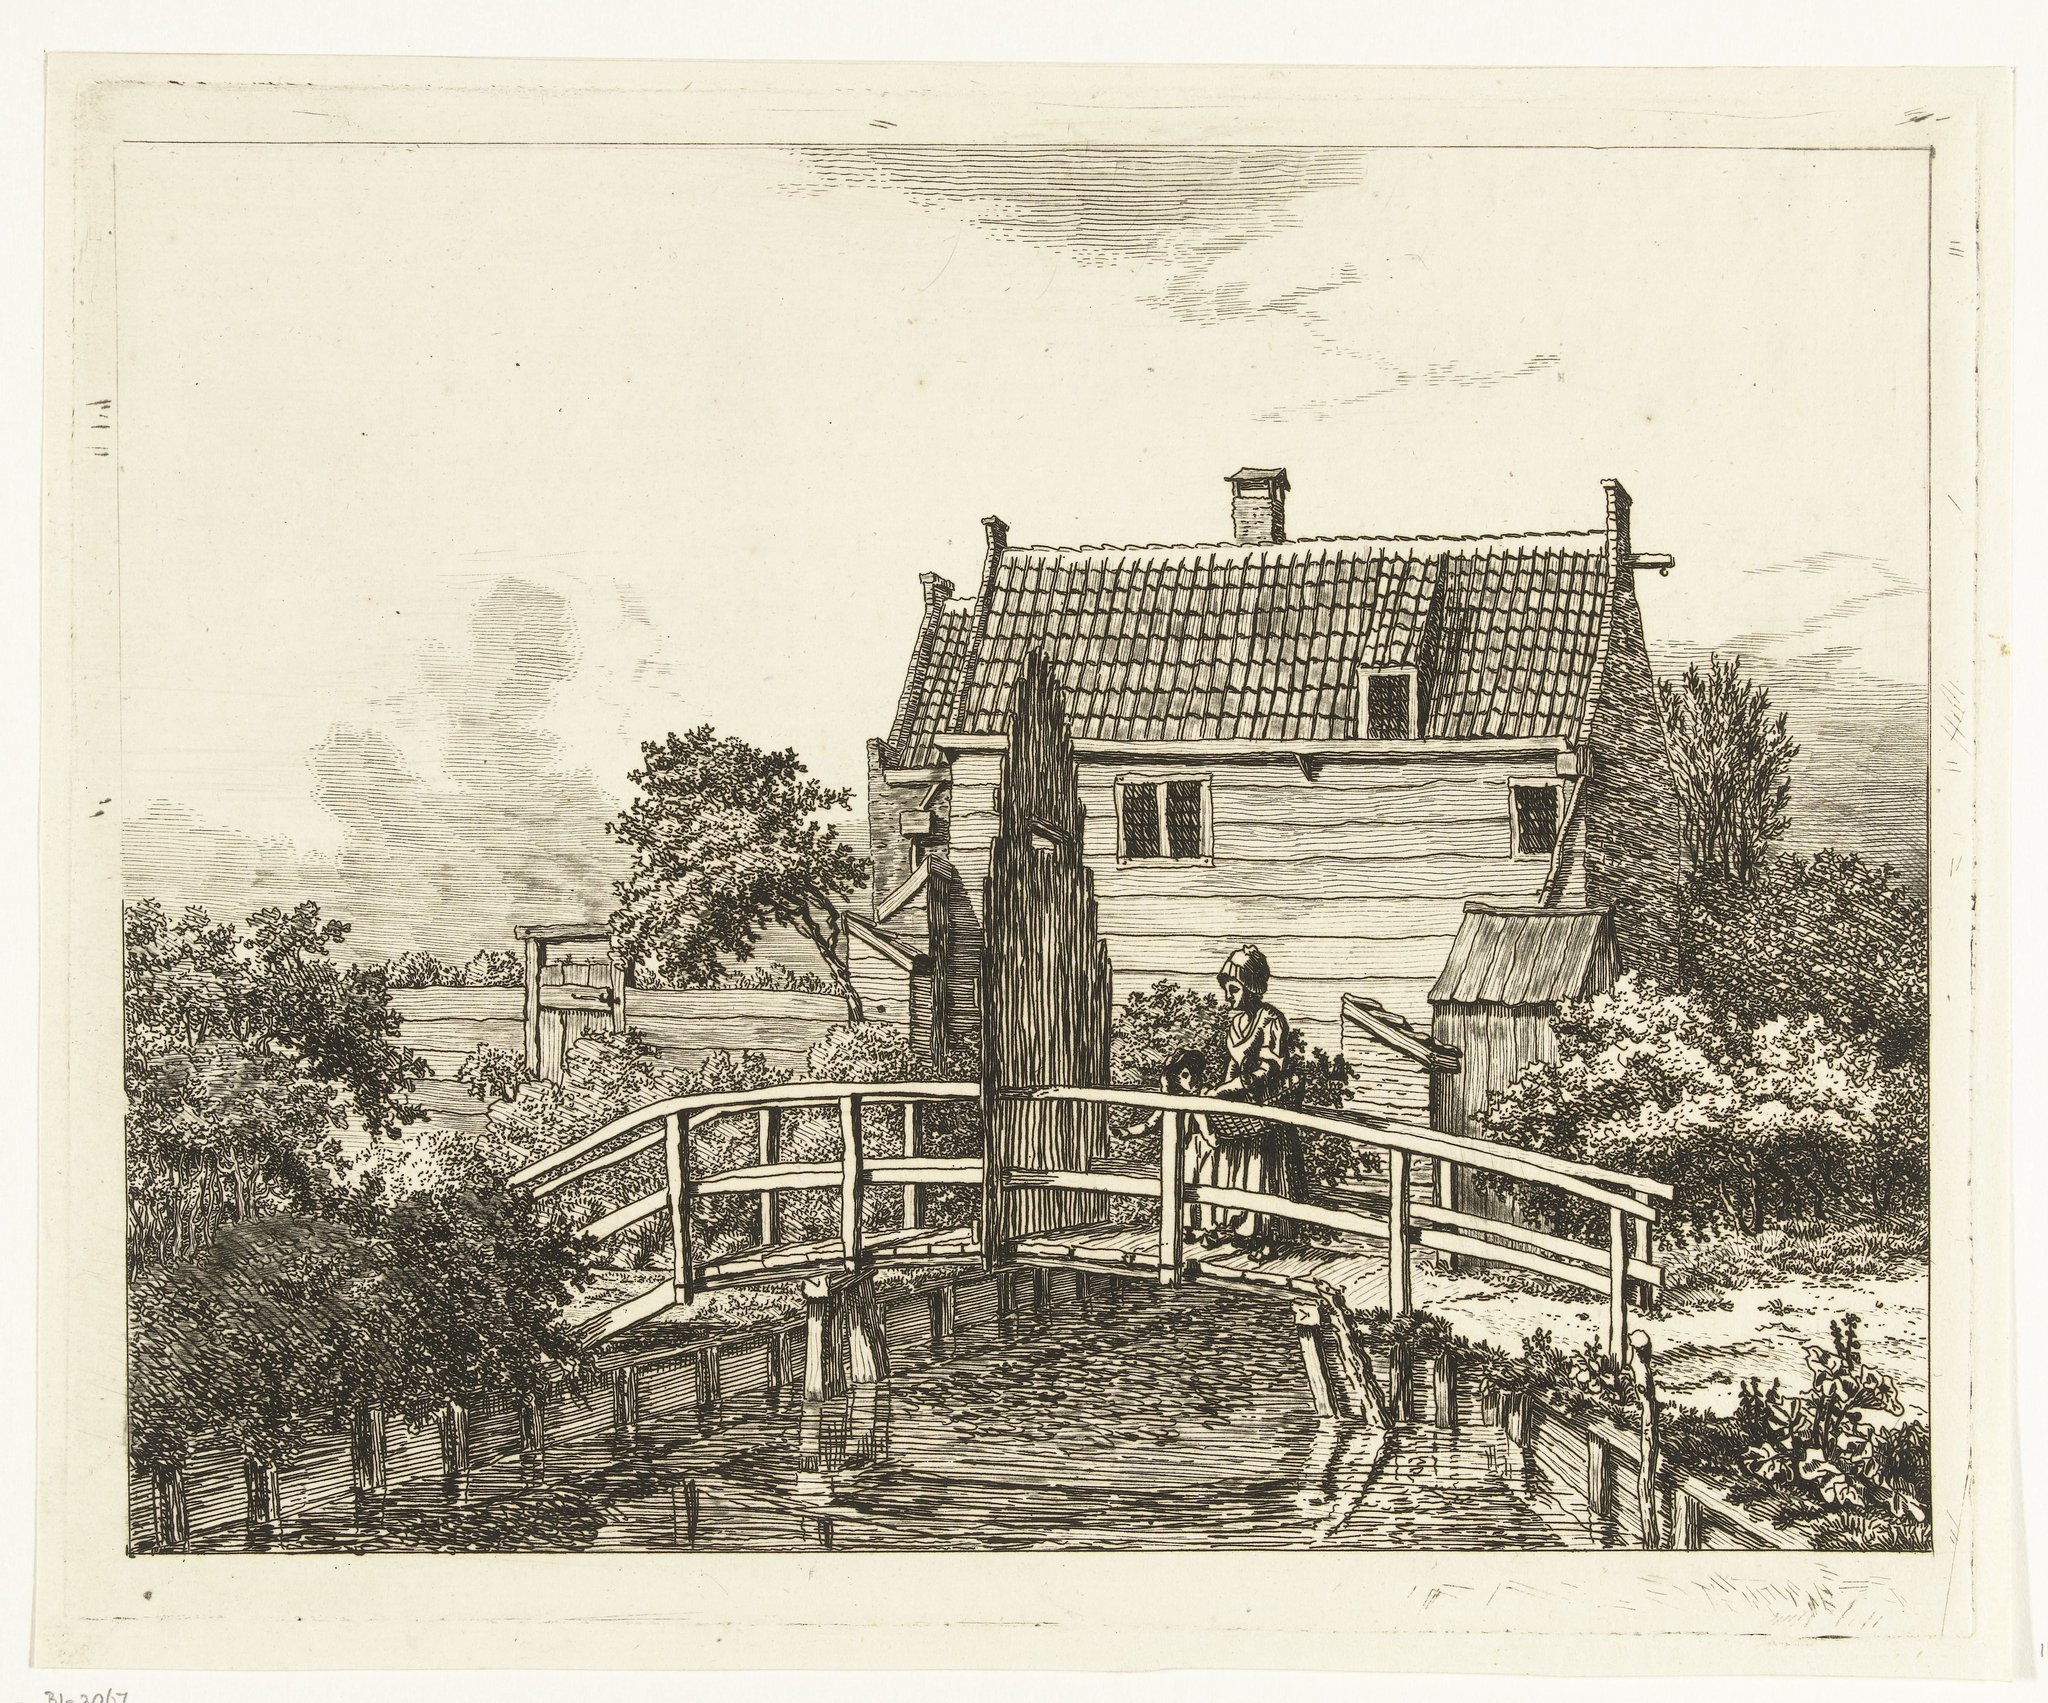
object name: print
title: Jan Hanzenpad buiten de Raampoort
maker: anthonie van den bos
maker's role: draughtsman, print maker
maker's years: 1763-1838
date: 1778-1838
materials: paper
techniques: etching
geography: netherlands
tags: bridge with structure, i.e. cover or buildings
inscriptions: collector's mark: Lugt 2228